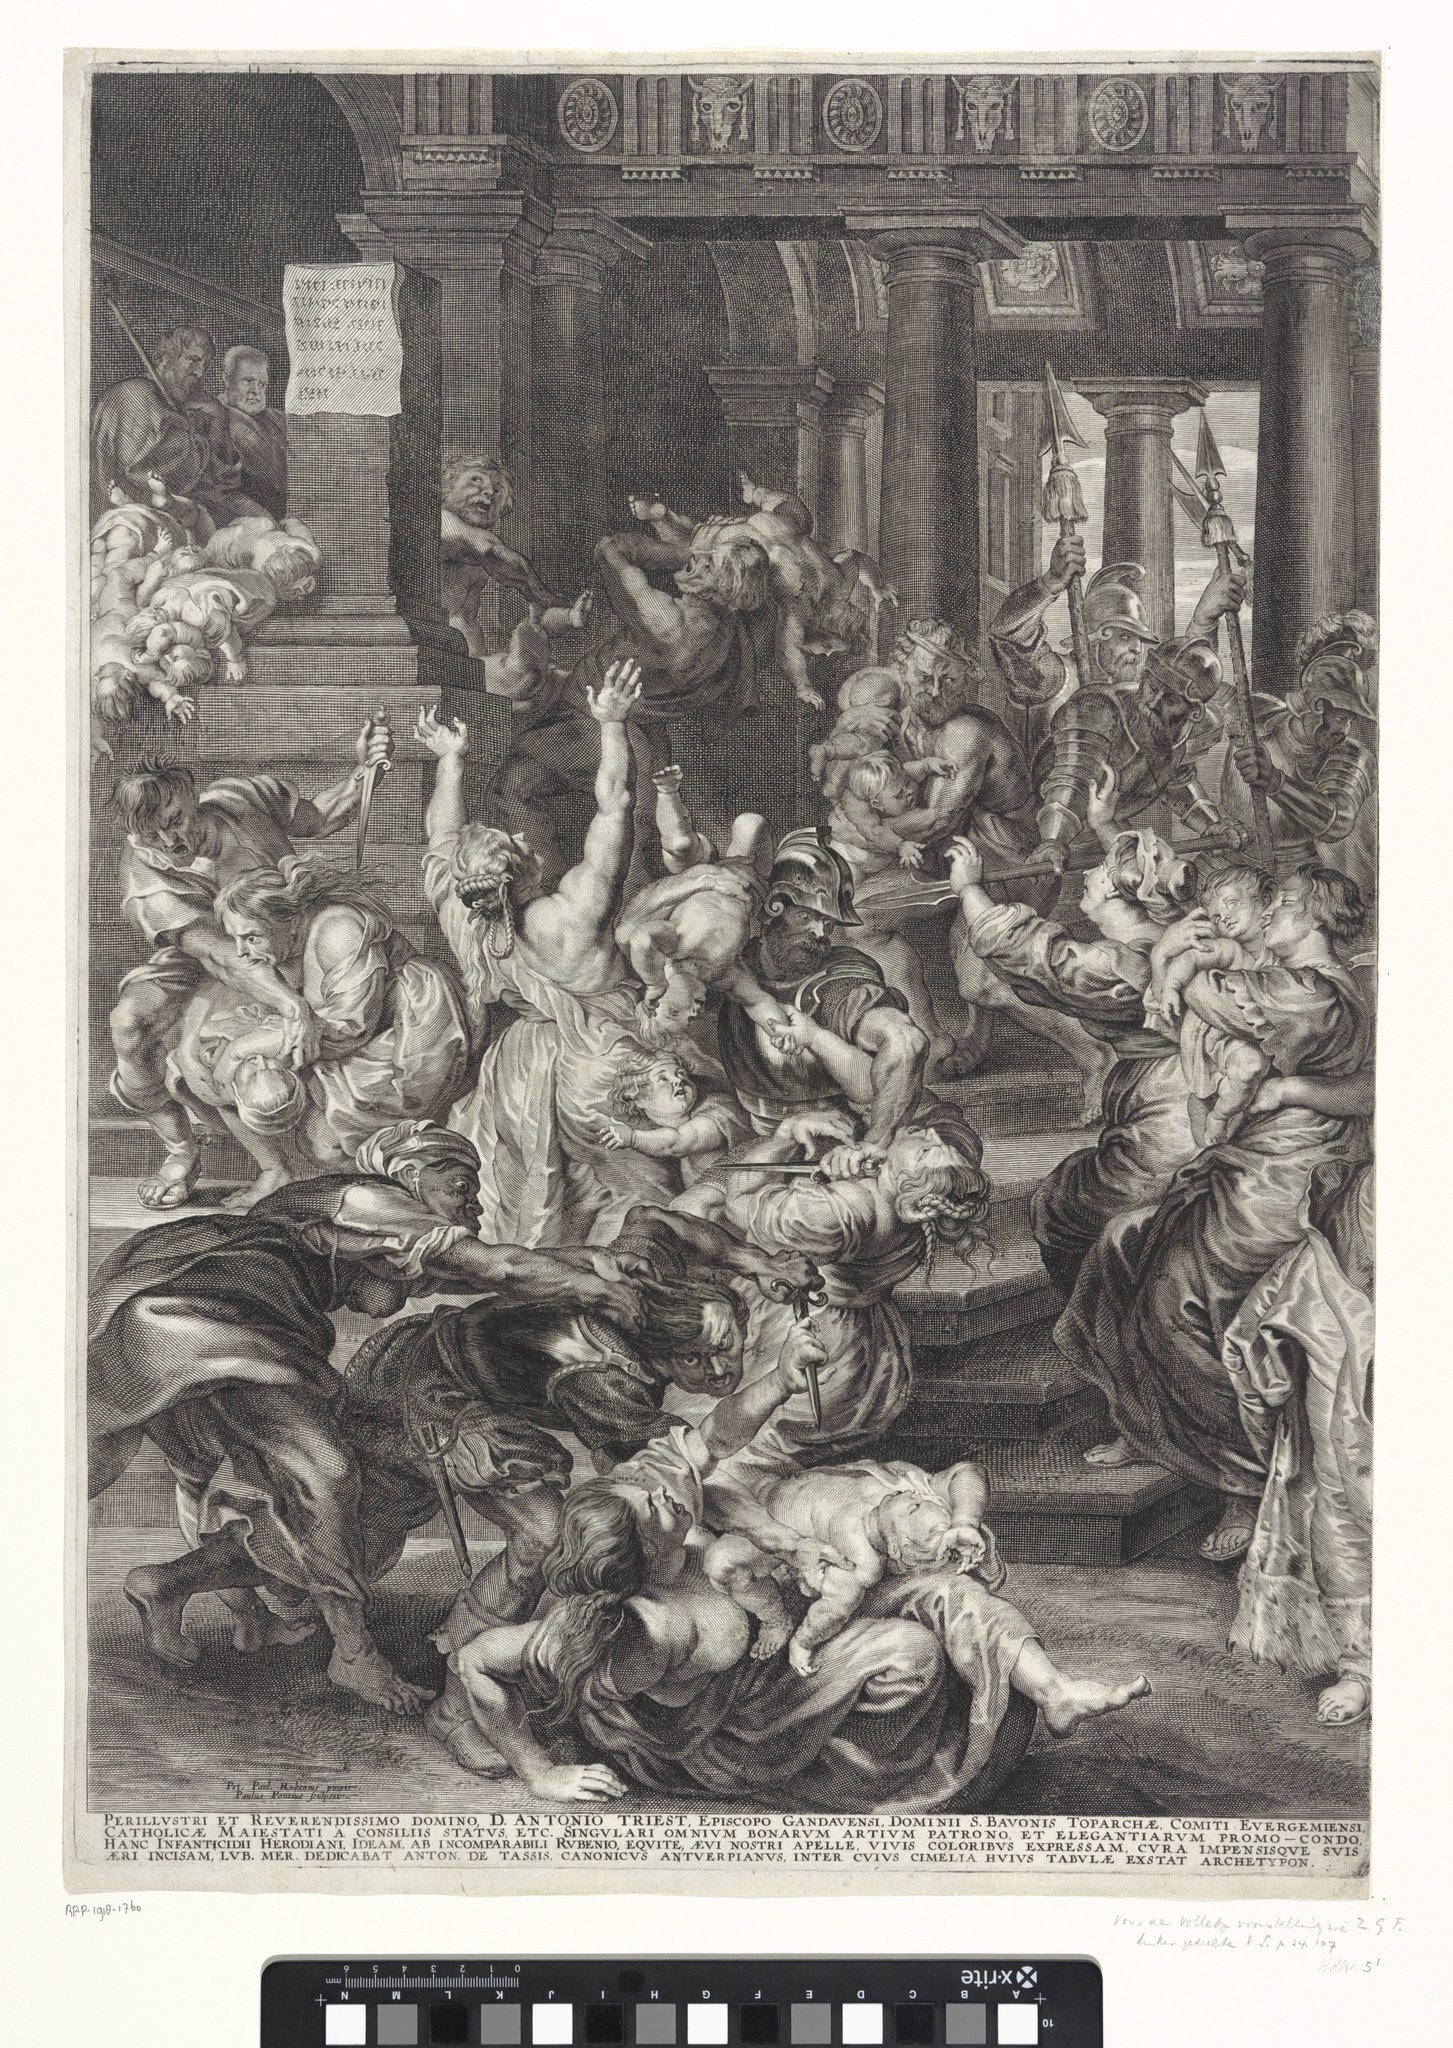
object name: print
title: Kindermoord te Betlehem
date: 1643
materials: paper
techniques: engraving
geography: antwerp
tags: the massacre of the innocents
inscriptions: collector's mark: Lugt 2233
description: Op de binnenplaats van Herodes' paleis te Betlehem proberen moeders hun kinderen te beschermen tegen diens soldaten. De soldaten hebben de opdracht gekregen alle jongens van twee jaar en jonger te vermoorden. De soldaten rukken de kinderen uit de armen van de wanhopige moeders. In de marge een opdracht in het Latijn.